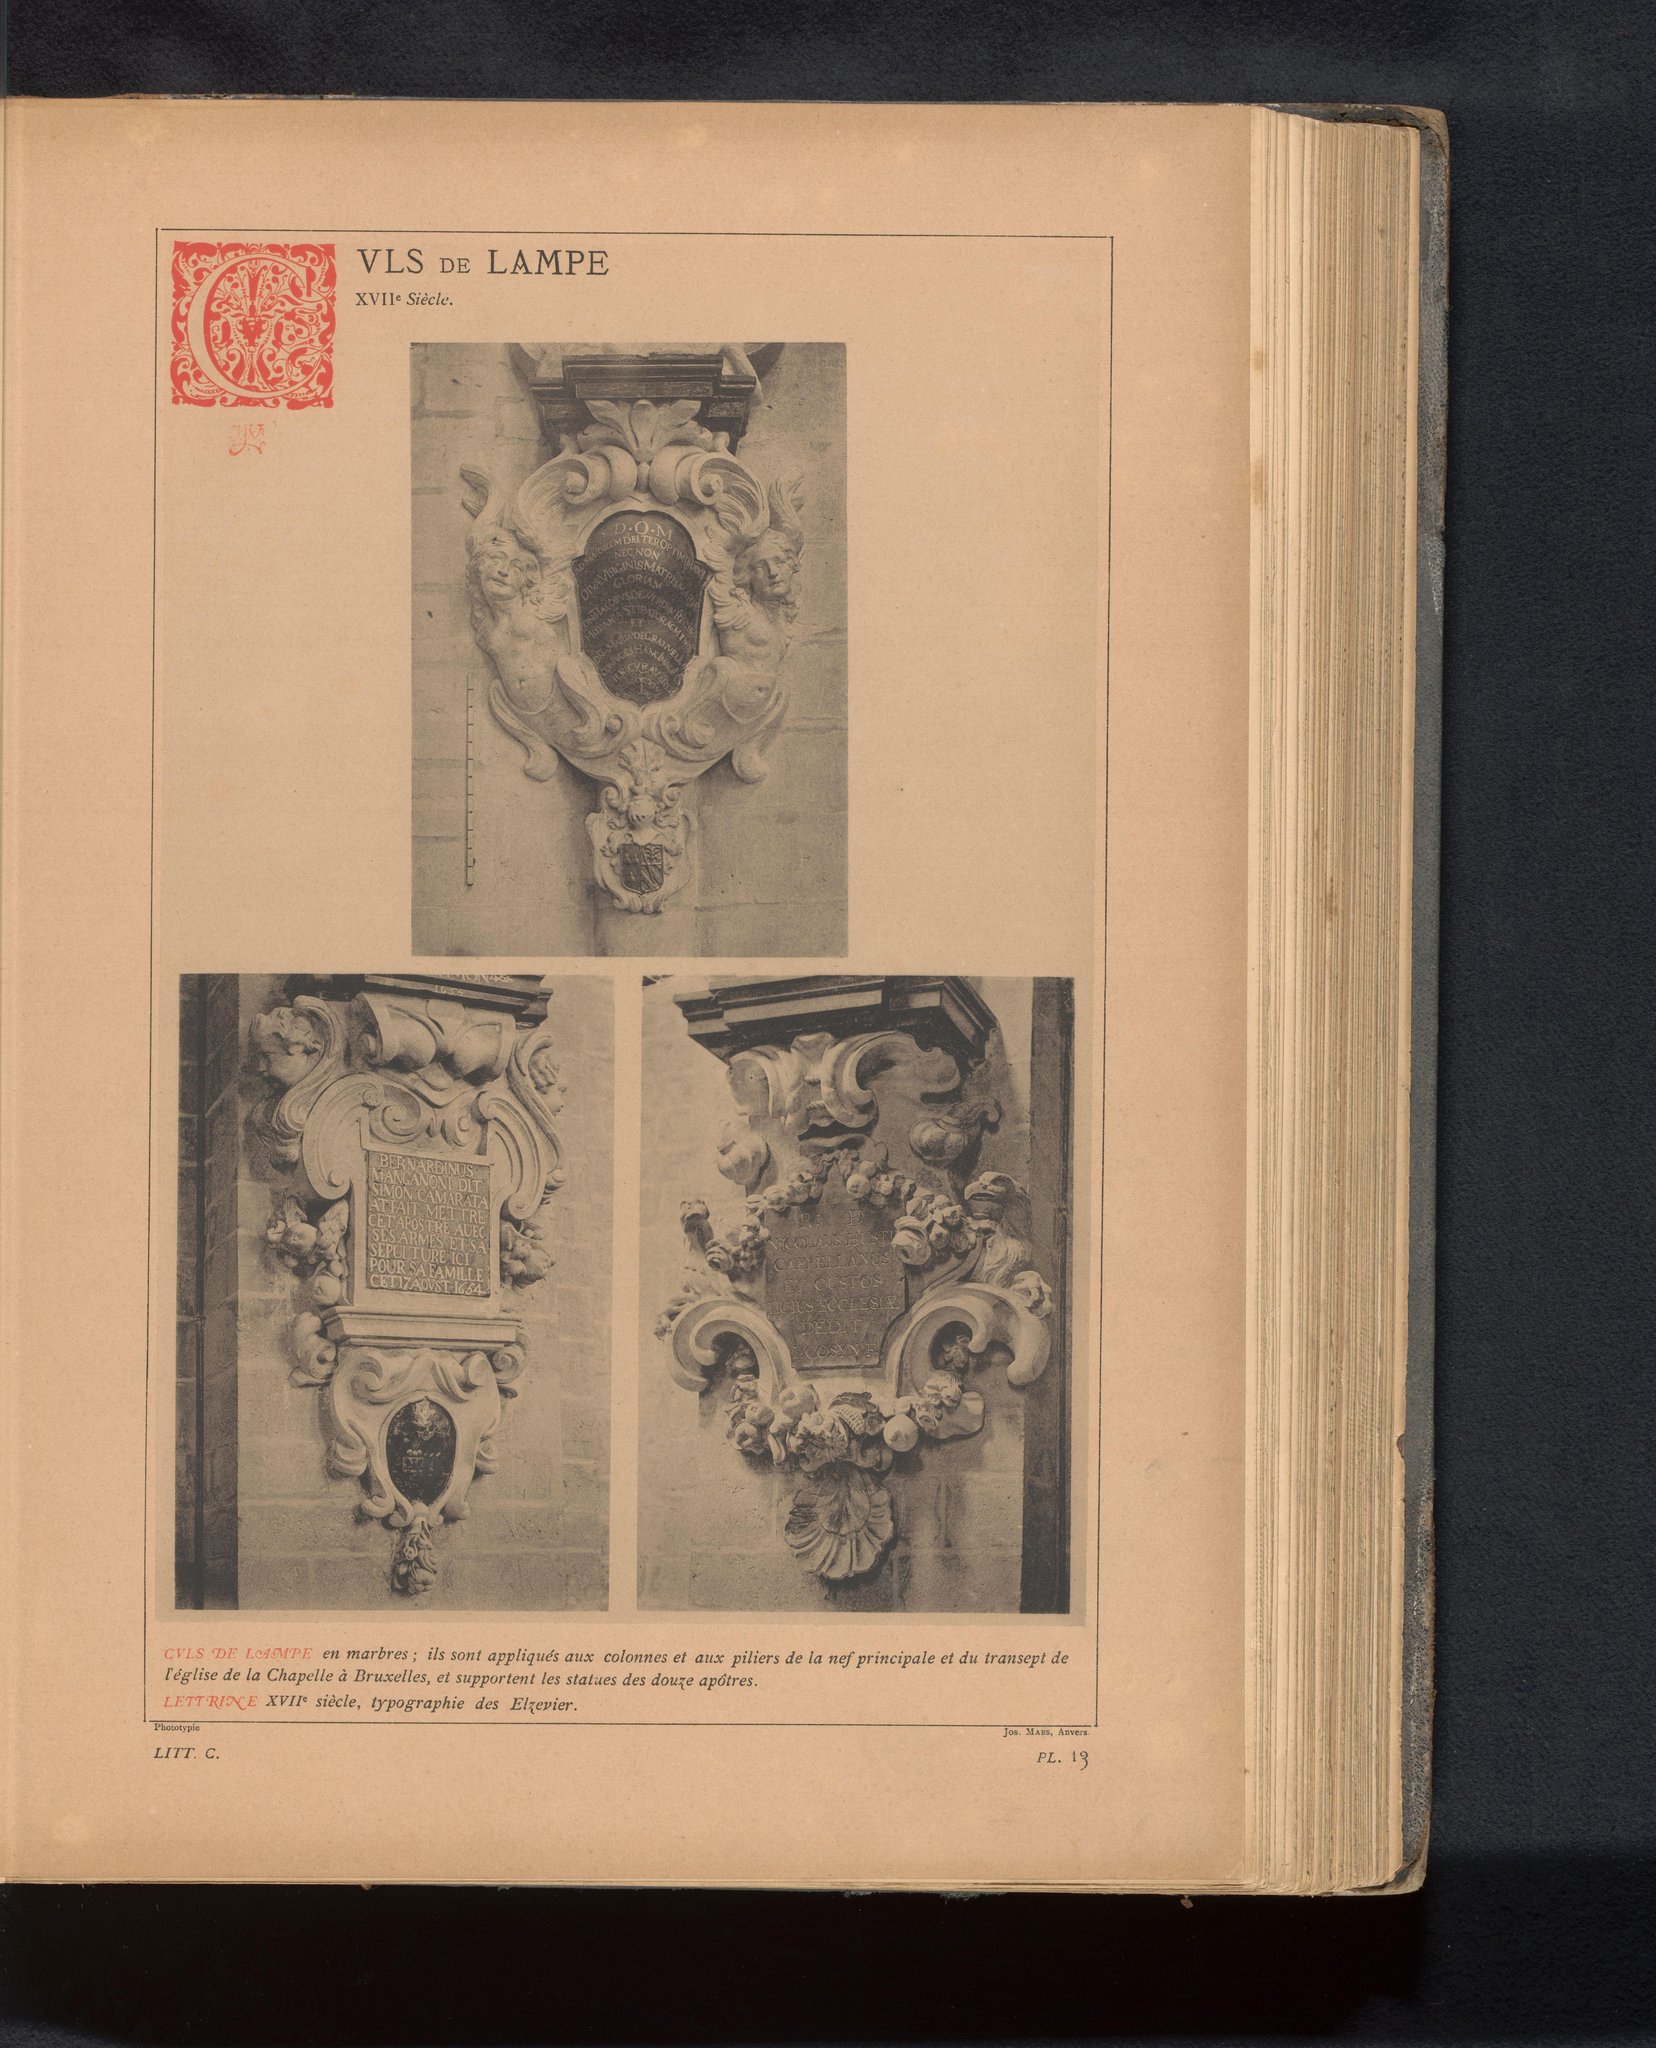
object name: page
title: Culs de lampe, XVIIe Siècle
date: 1875-1880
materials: paper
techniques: photograph, photolithography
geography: kapellekerk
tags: grave, tomb and other grave-forms and grave-markers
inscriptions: monogram: ‘JJvY’, inscription: ‘Culs de lampe (...)’, inscription: ‘LITT. C. - PL. 13’